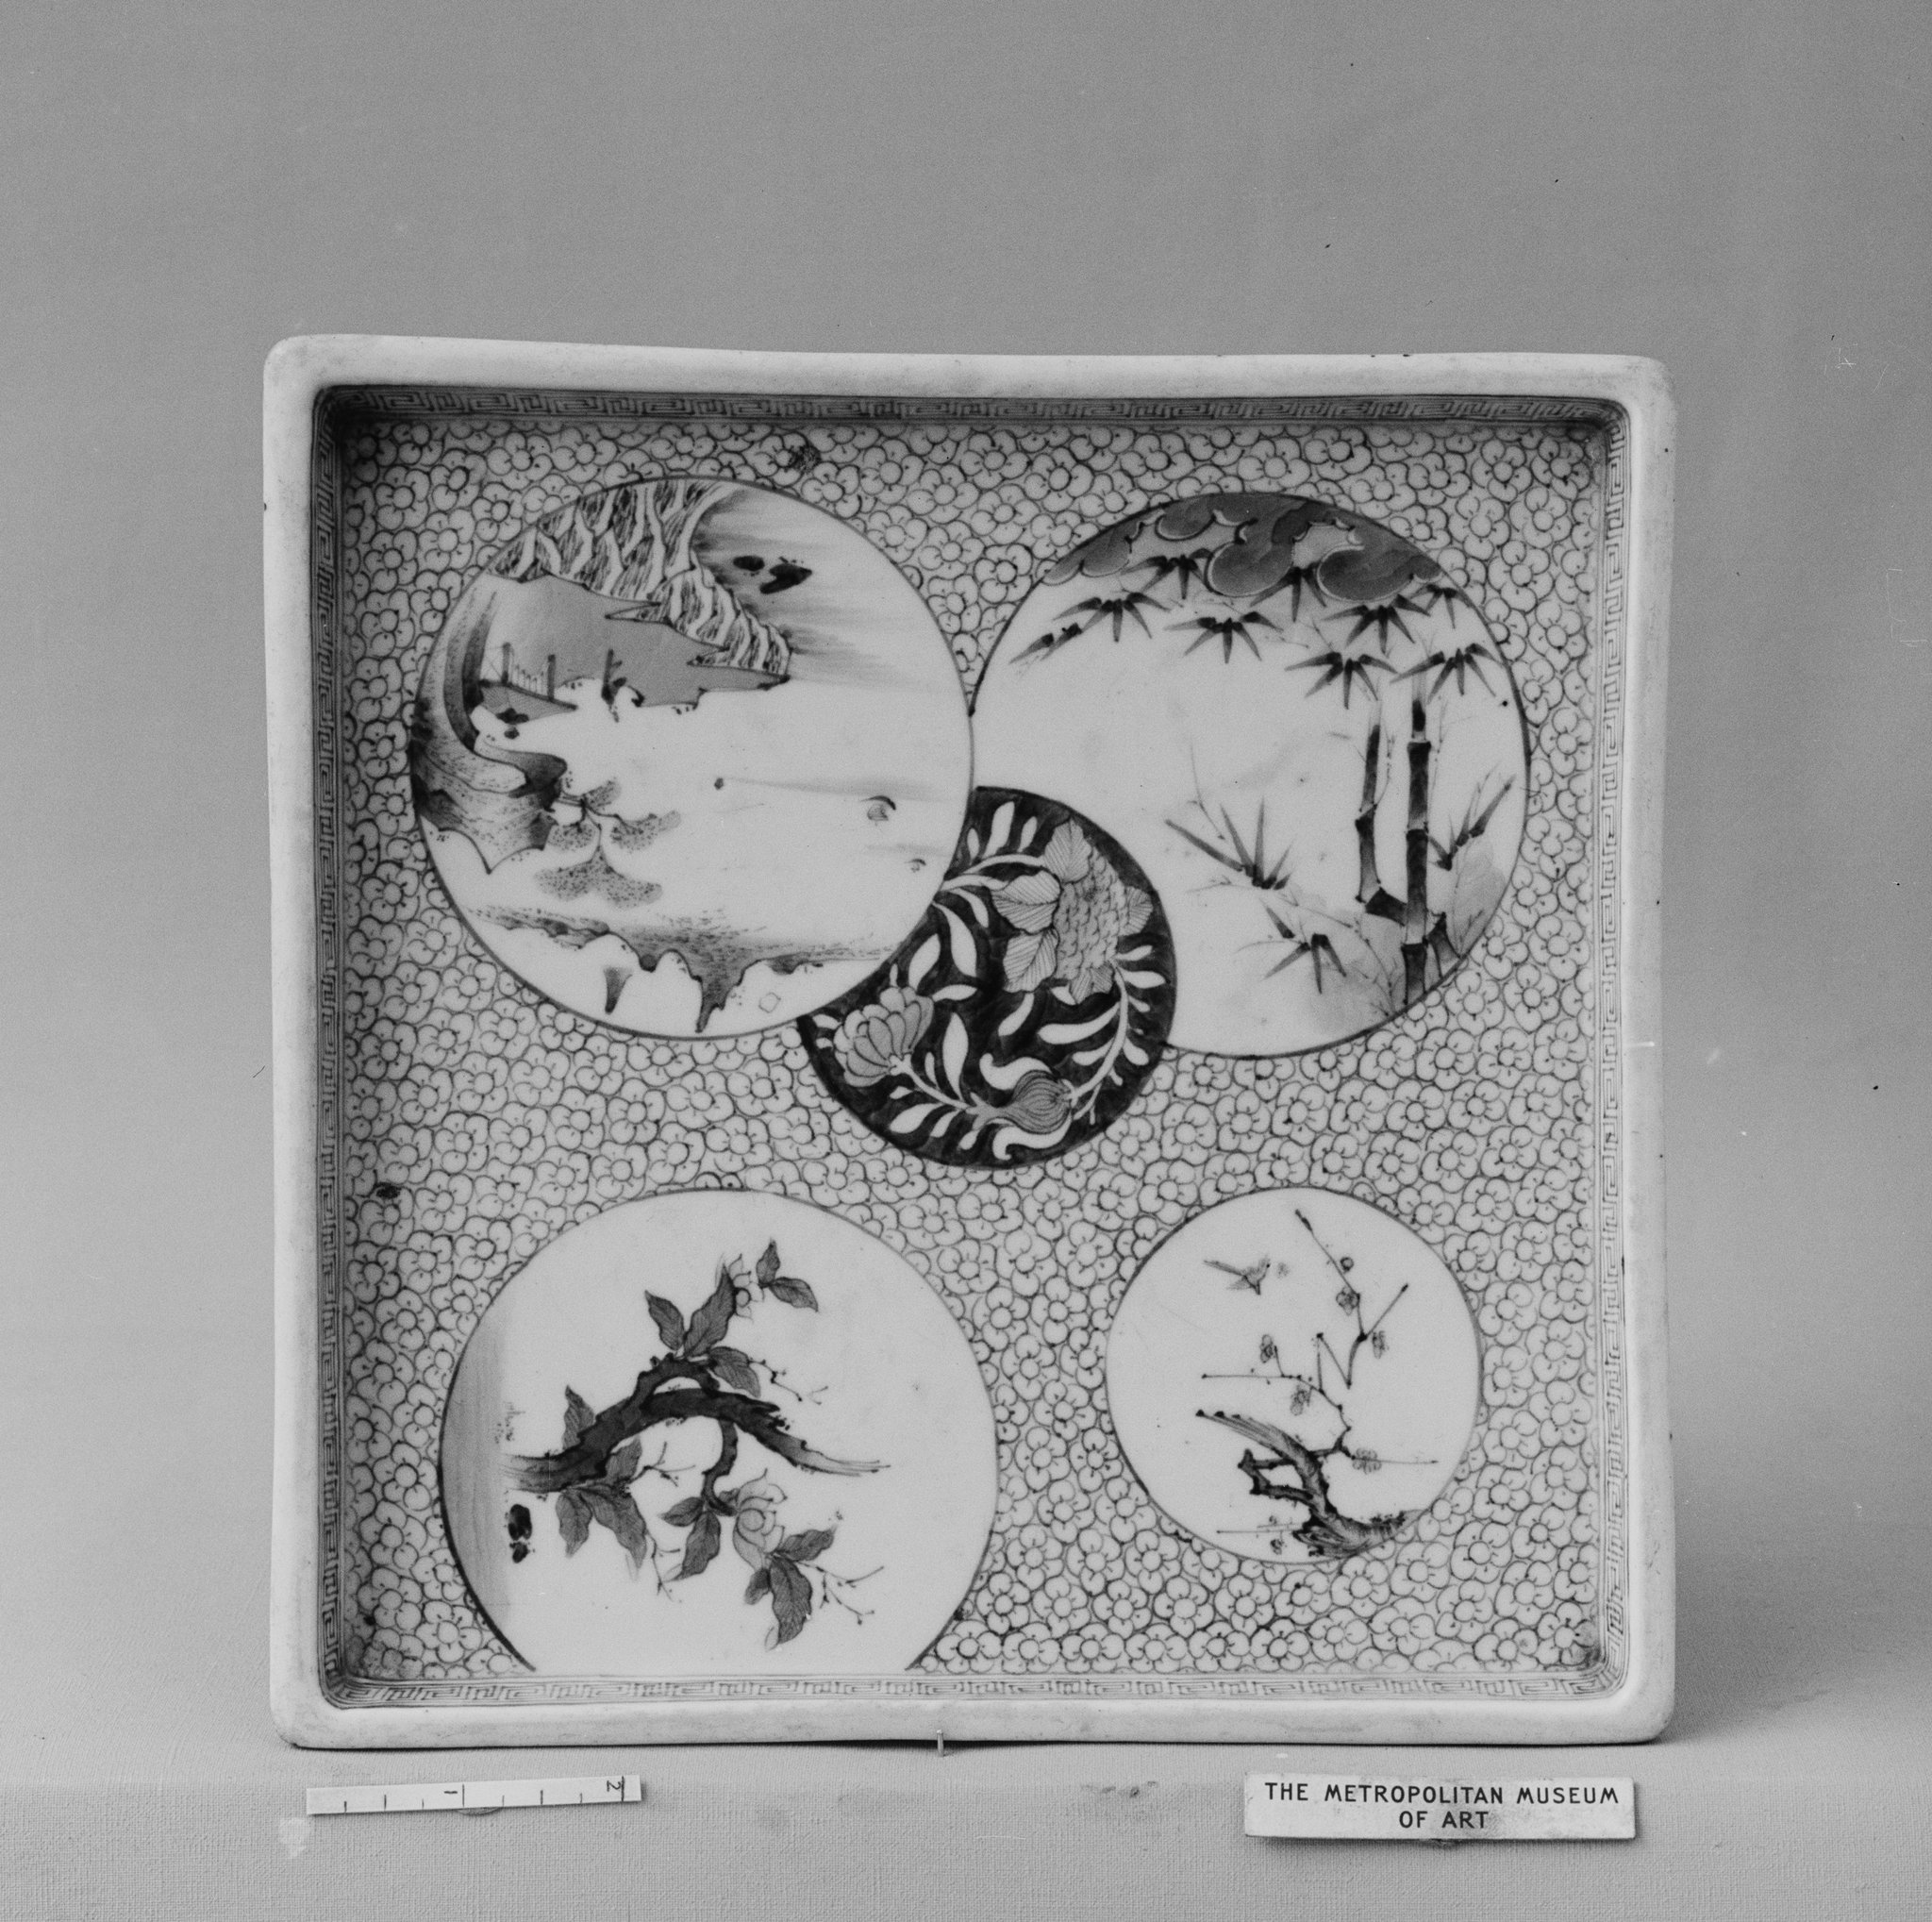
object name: tray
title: Square Tray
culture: japanese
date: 1720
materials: glaze, porcelain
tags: flowers,bamboo